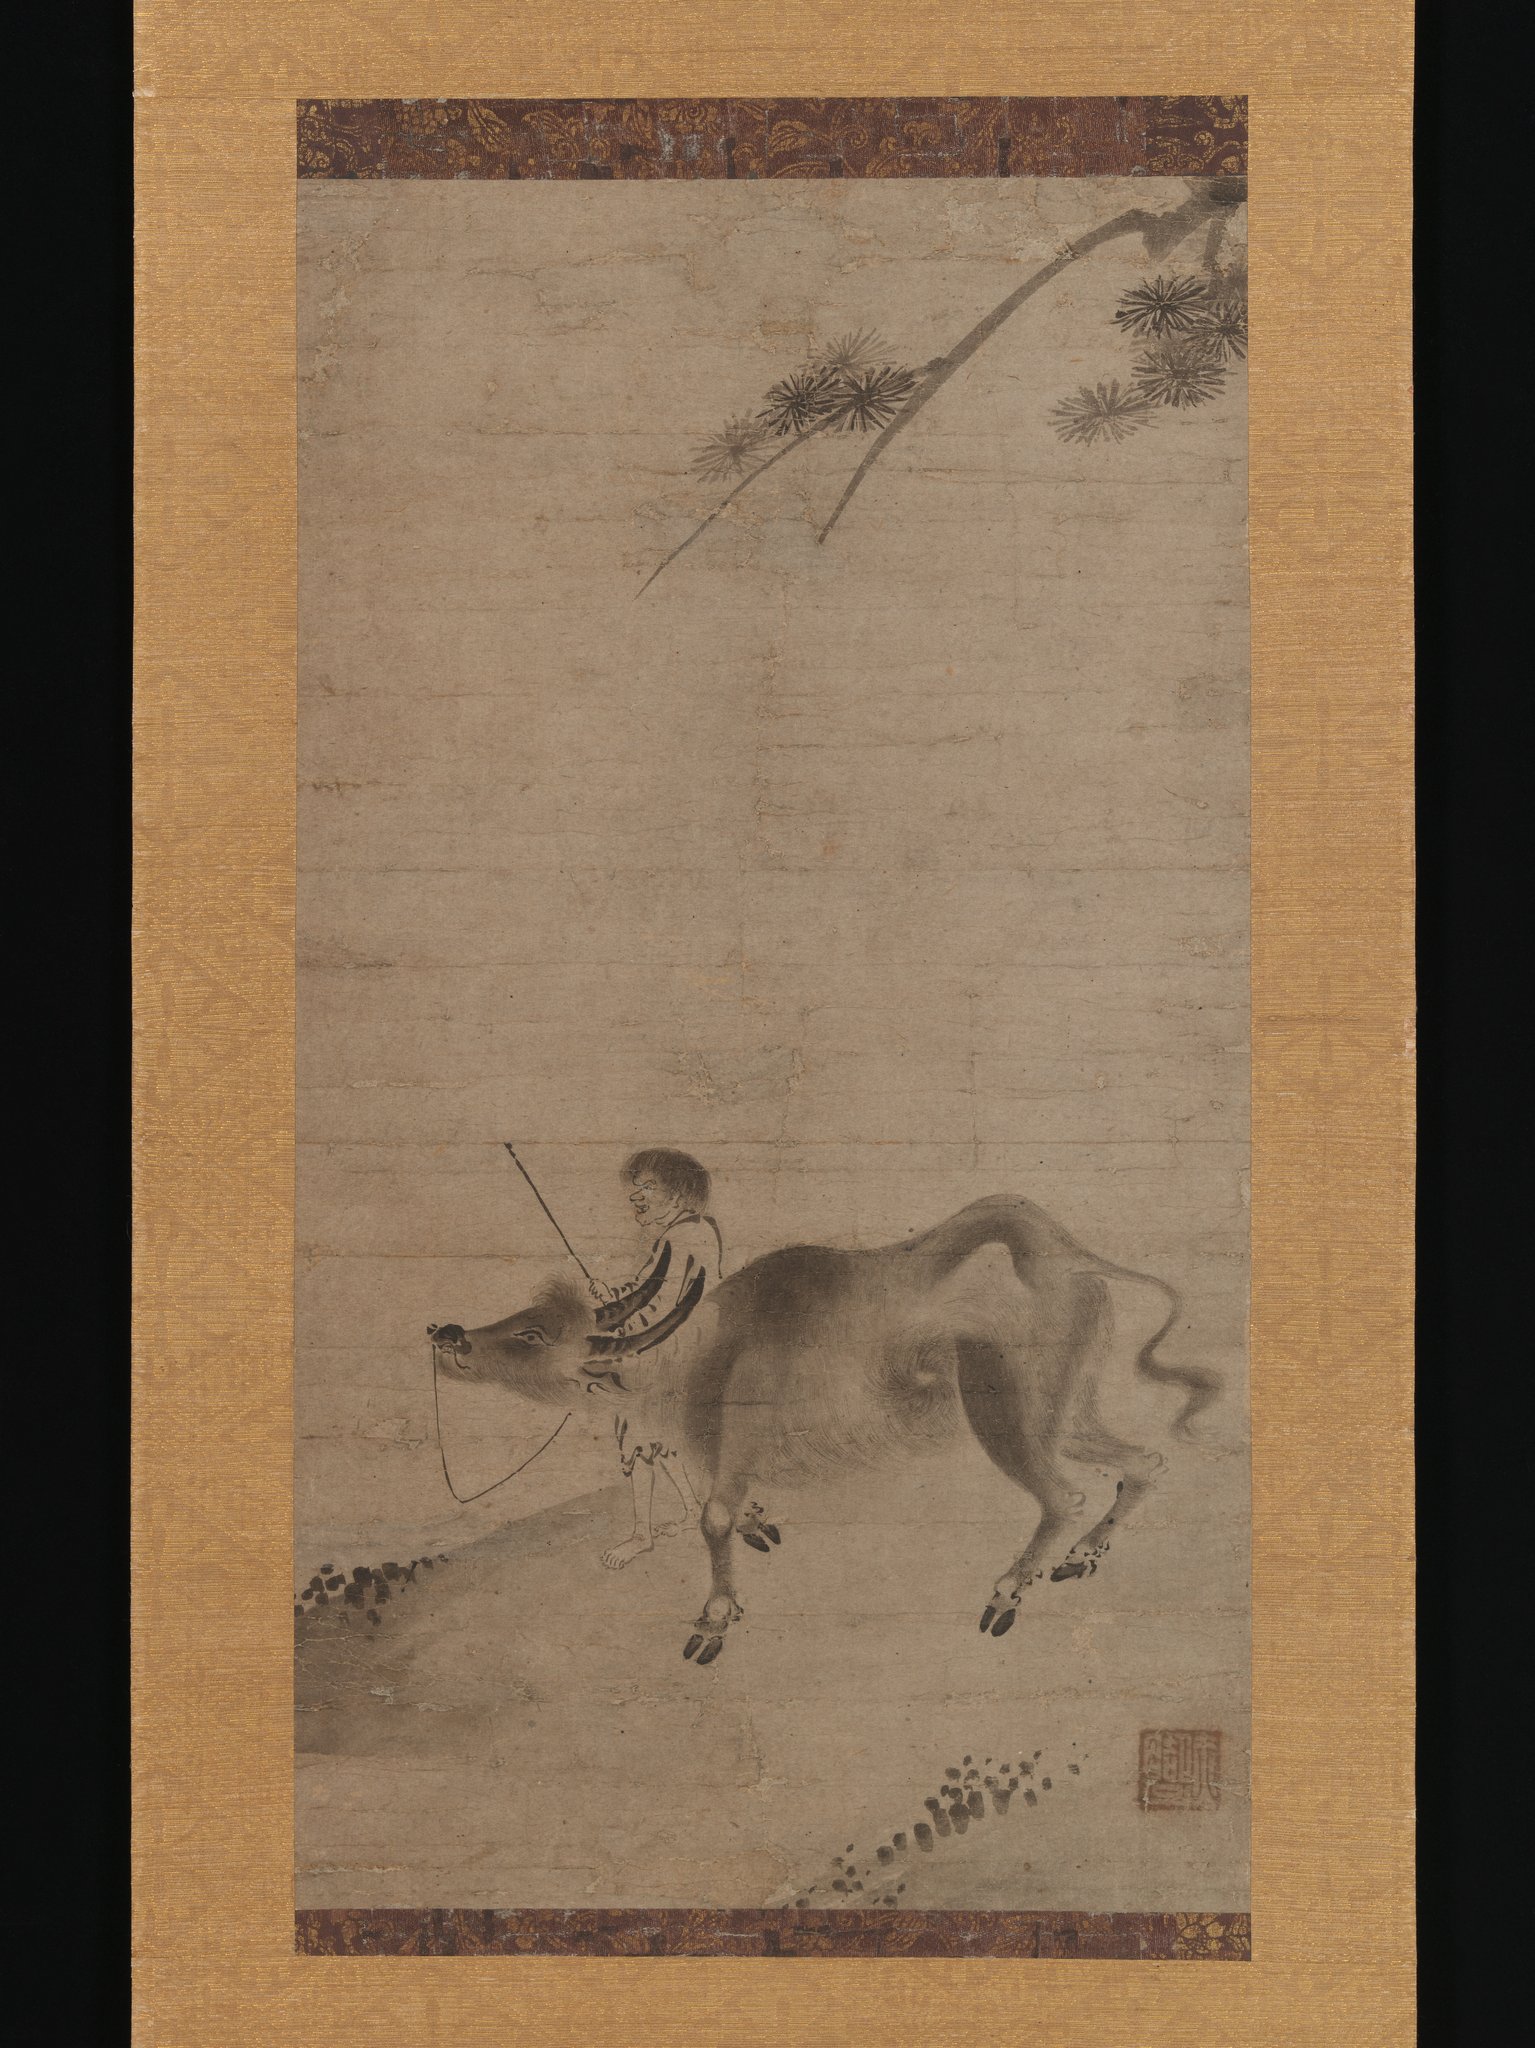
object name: hanging scroll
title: Oxherding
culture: japanese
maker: sekkyakushi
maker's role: artist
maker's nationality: japanese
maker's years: 1400-1499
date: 1401-1450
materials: ink, paper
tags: boys,ox